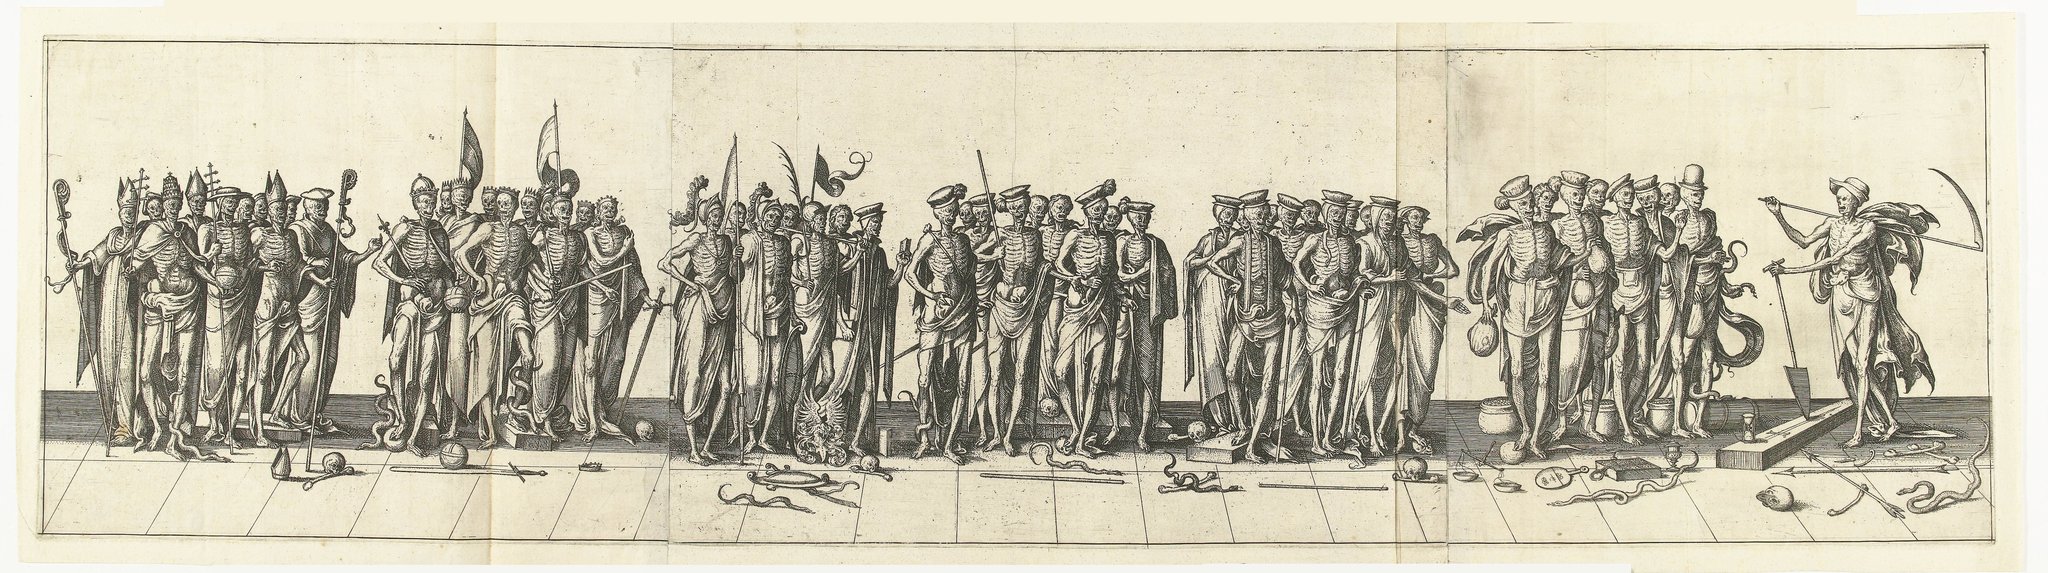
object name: print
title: Optocht van doden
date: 1559-1608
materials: paper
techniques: etching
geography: southern netherlands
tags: ghent, charles v (holy roman emperor and king of spain), symbols and personifications of death, triumphs (allegorical and symbolic), brussels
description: Optocht van doden, aangevoerd door de Dood. Van links naar rechts: kerkelijke vorsten, wereldse vorsten, soldaten, geleerden en rechters en koopmannen. Rechts de Dood als tuinman met spade in de hand en zeis over de schouder. Geheel op drie bladen aan elkaar geplakt.